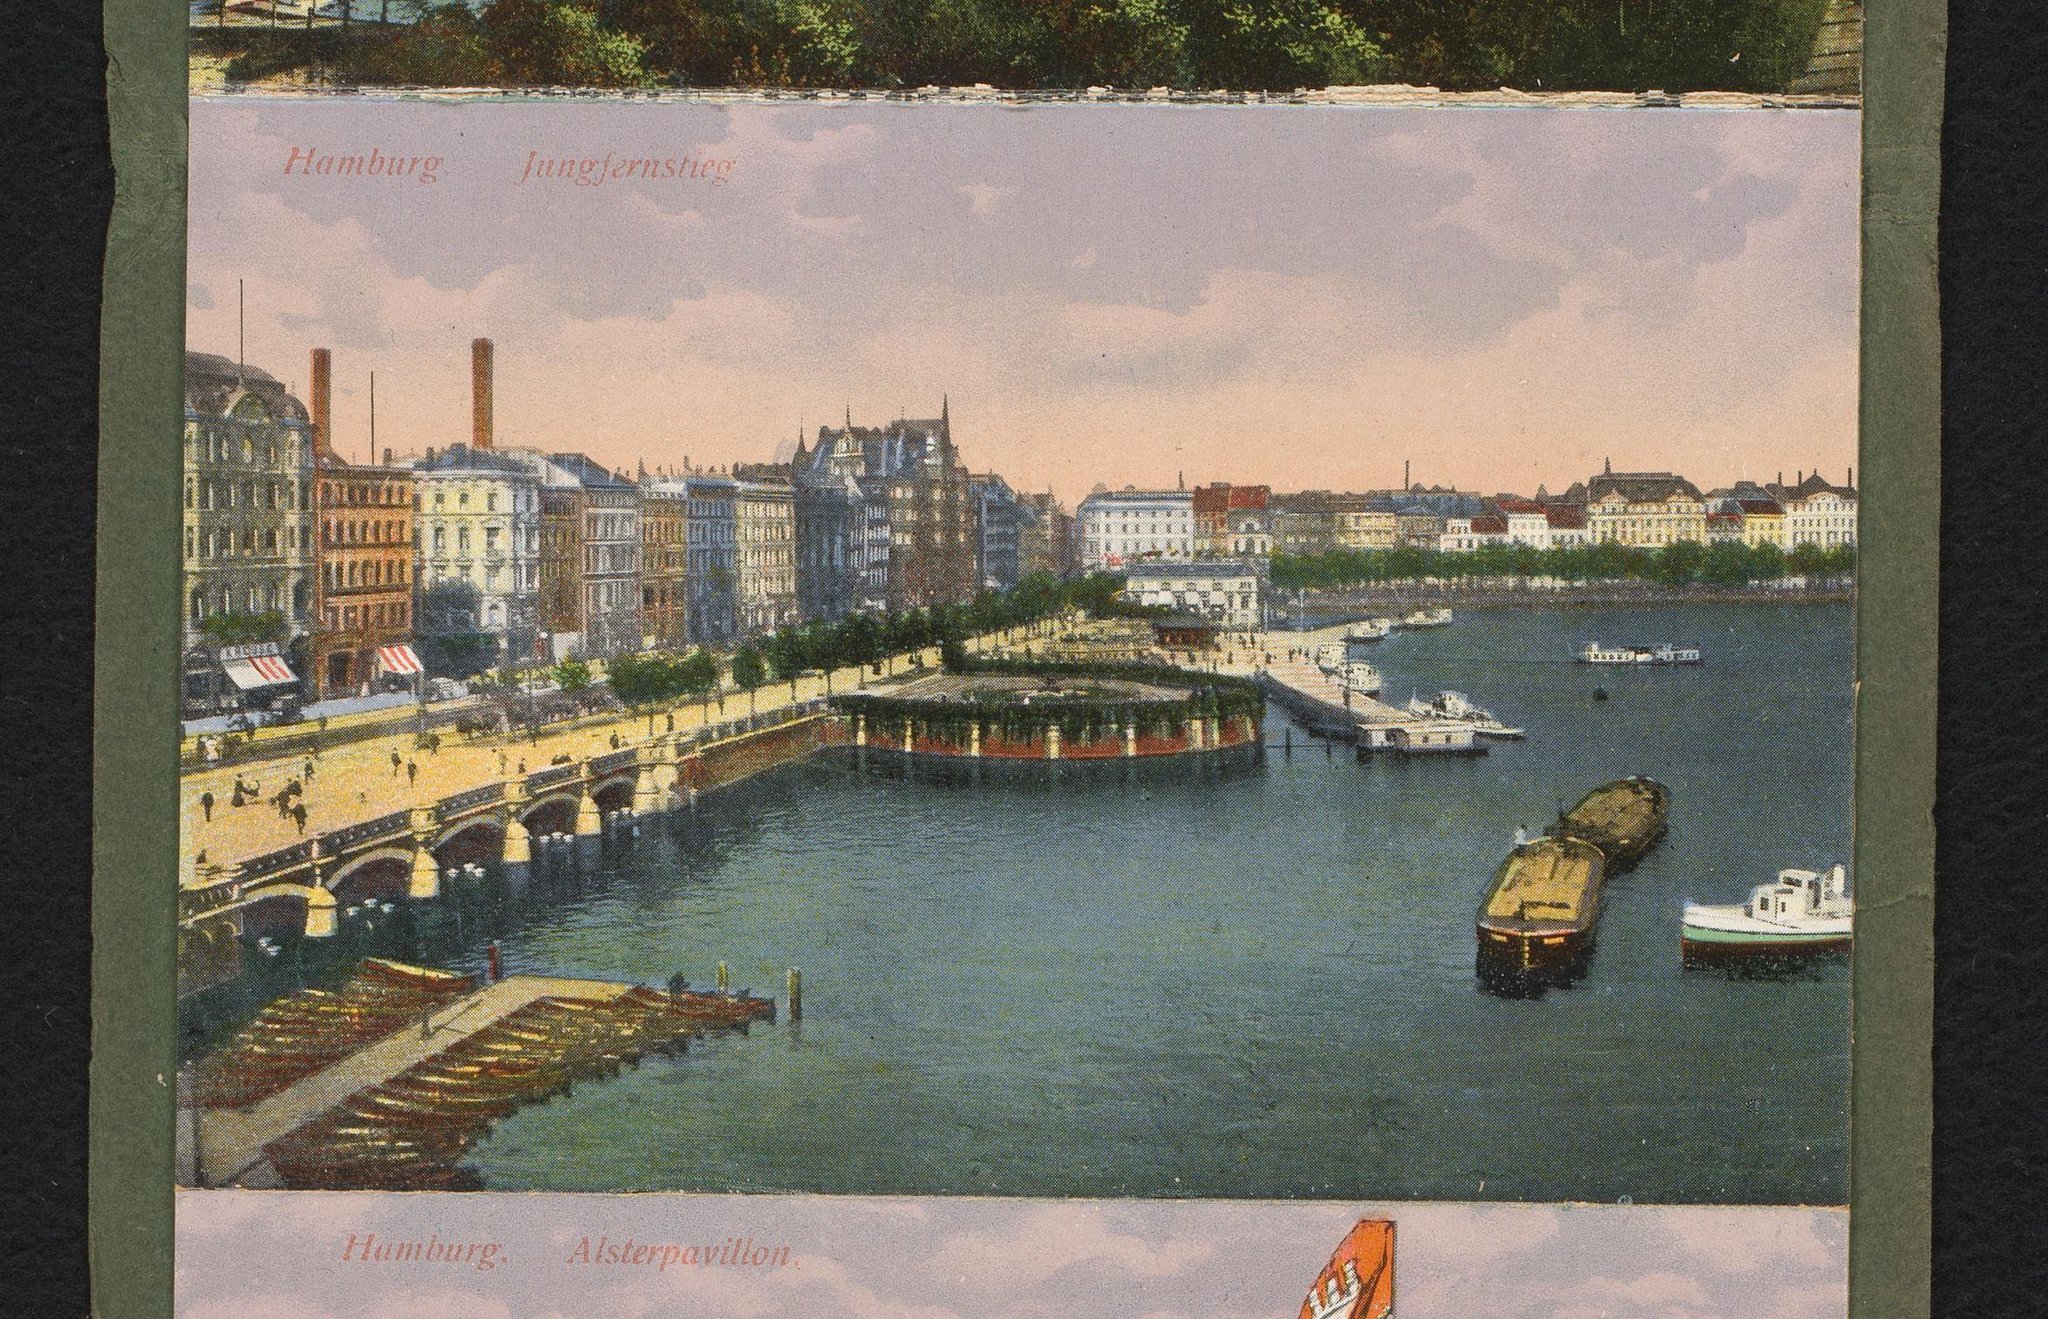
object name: photomechanical print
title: Hamburg. Jungfernstieg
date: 1905-1930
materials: cardboard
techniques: lithograph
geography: hamburg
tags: lake, avenue, boulevard, promenade, esplanade